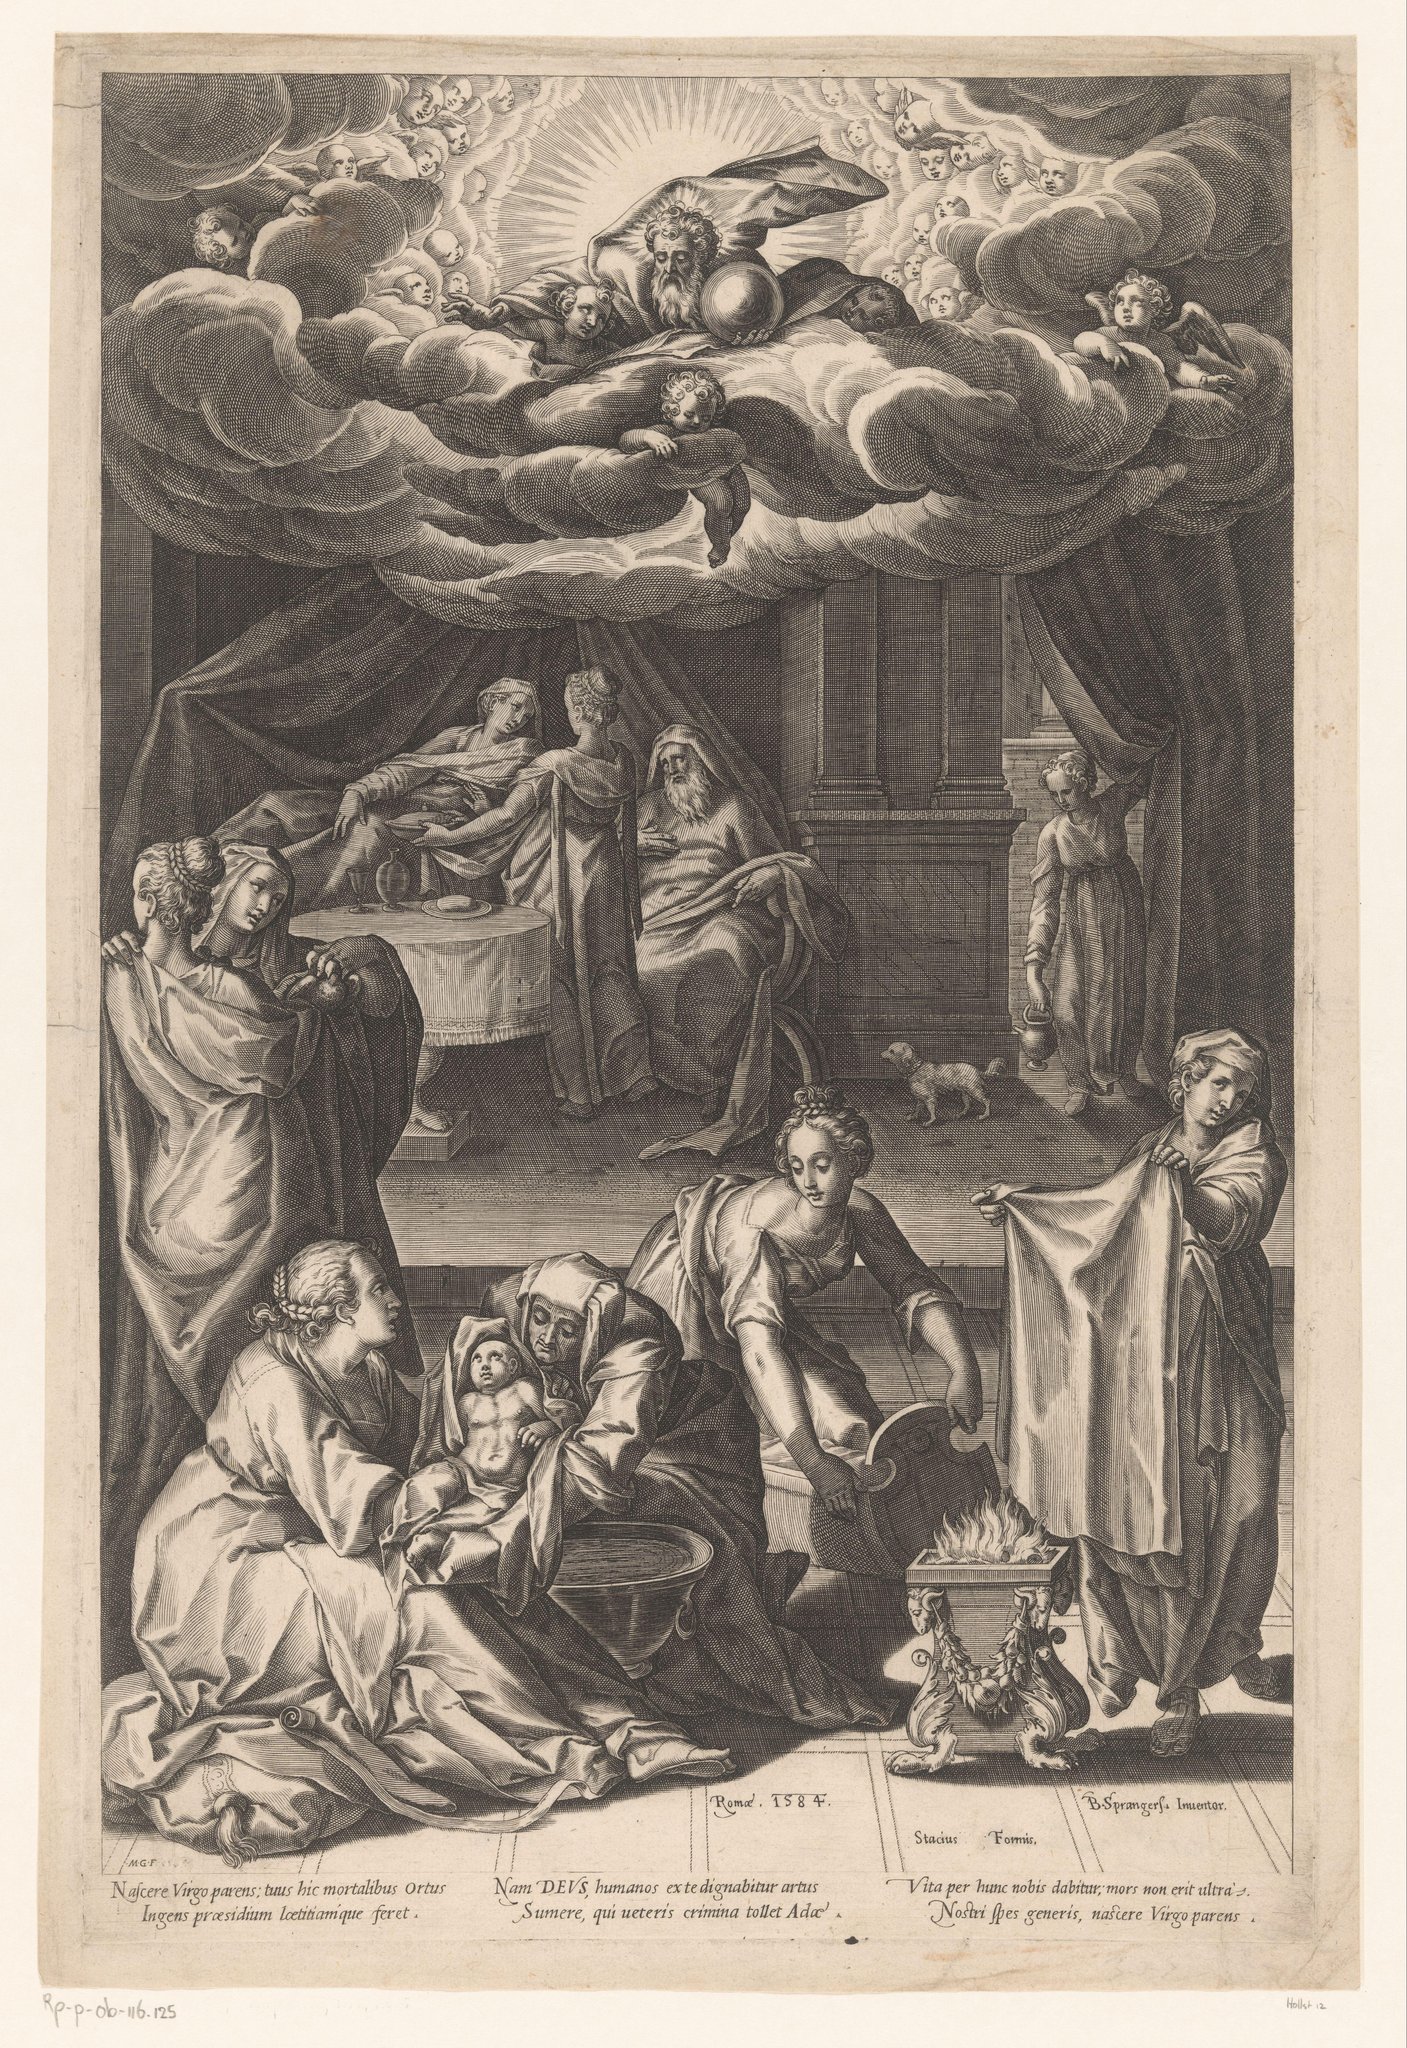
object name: print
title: Birth of the Virgin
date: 1584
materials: paper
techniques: engraving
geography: rome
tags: cherubs, i.e. children's heads with wings, other representations ~ god the father, birth of mary, sitting or standing on clouds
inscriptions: collector's mark: Lugt 240